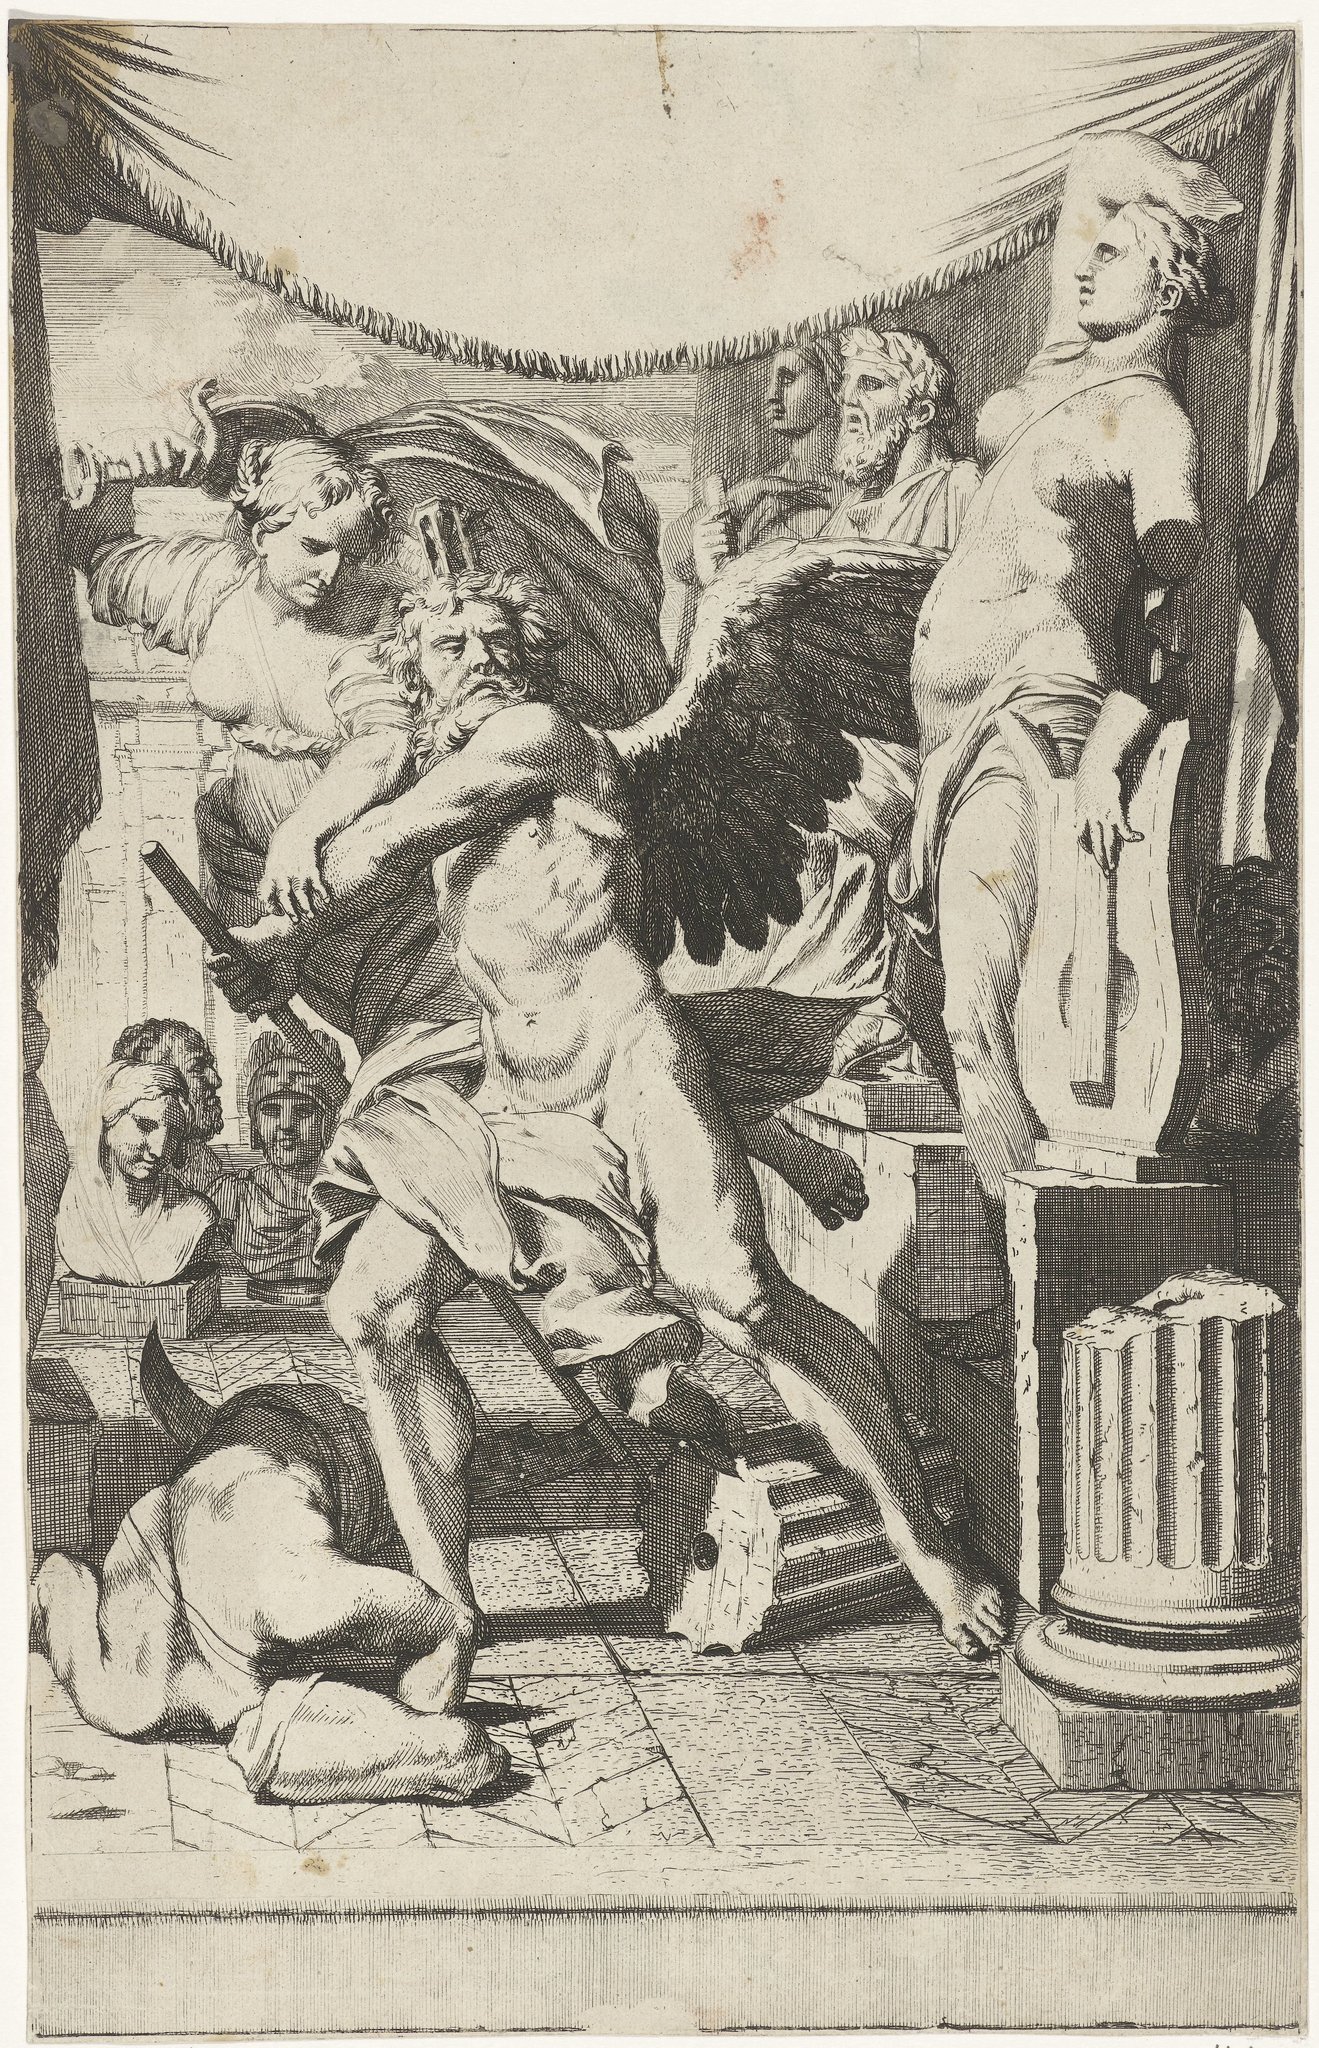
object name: print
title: Voorzichtigheid weerhoudt de Tijd ervan antieke beelden te vernietigen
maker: gerard de lairesse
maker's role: draughtsman, painter, print maker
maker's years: 1641-1711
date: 1670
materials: paper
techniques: etching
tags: prudence, 'prudentia'; 'prudenza' (ripa) ~ one of the four cardinal virtues, allegorical representations of the effects of time, sculpture, father time, man with wings and scythe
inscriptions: collector's mark: Lugt 2228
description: De Tijd (Chronos, gevleugelde zandloper) wil met een stok uithalen om een antiek beeld stuk te slaan. Hij wordt hierin tegengehouden door de Voorzichtigheid (Prudentia, slang met spiegel) die zijn arm heeft vastgepakt. Links ligt een reeds vernield beeld op de grond.